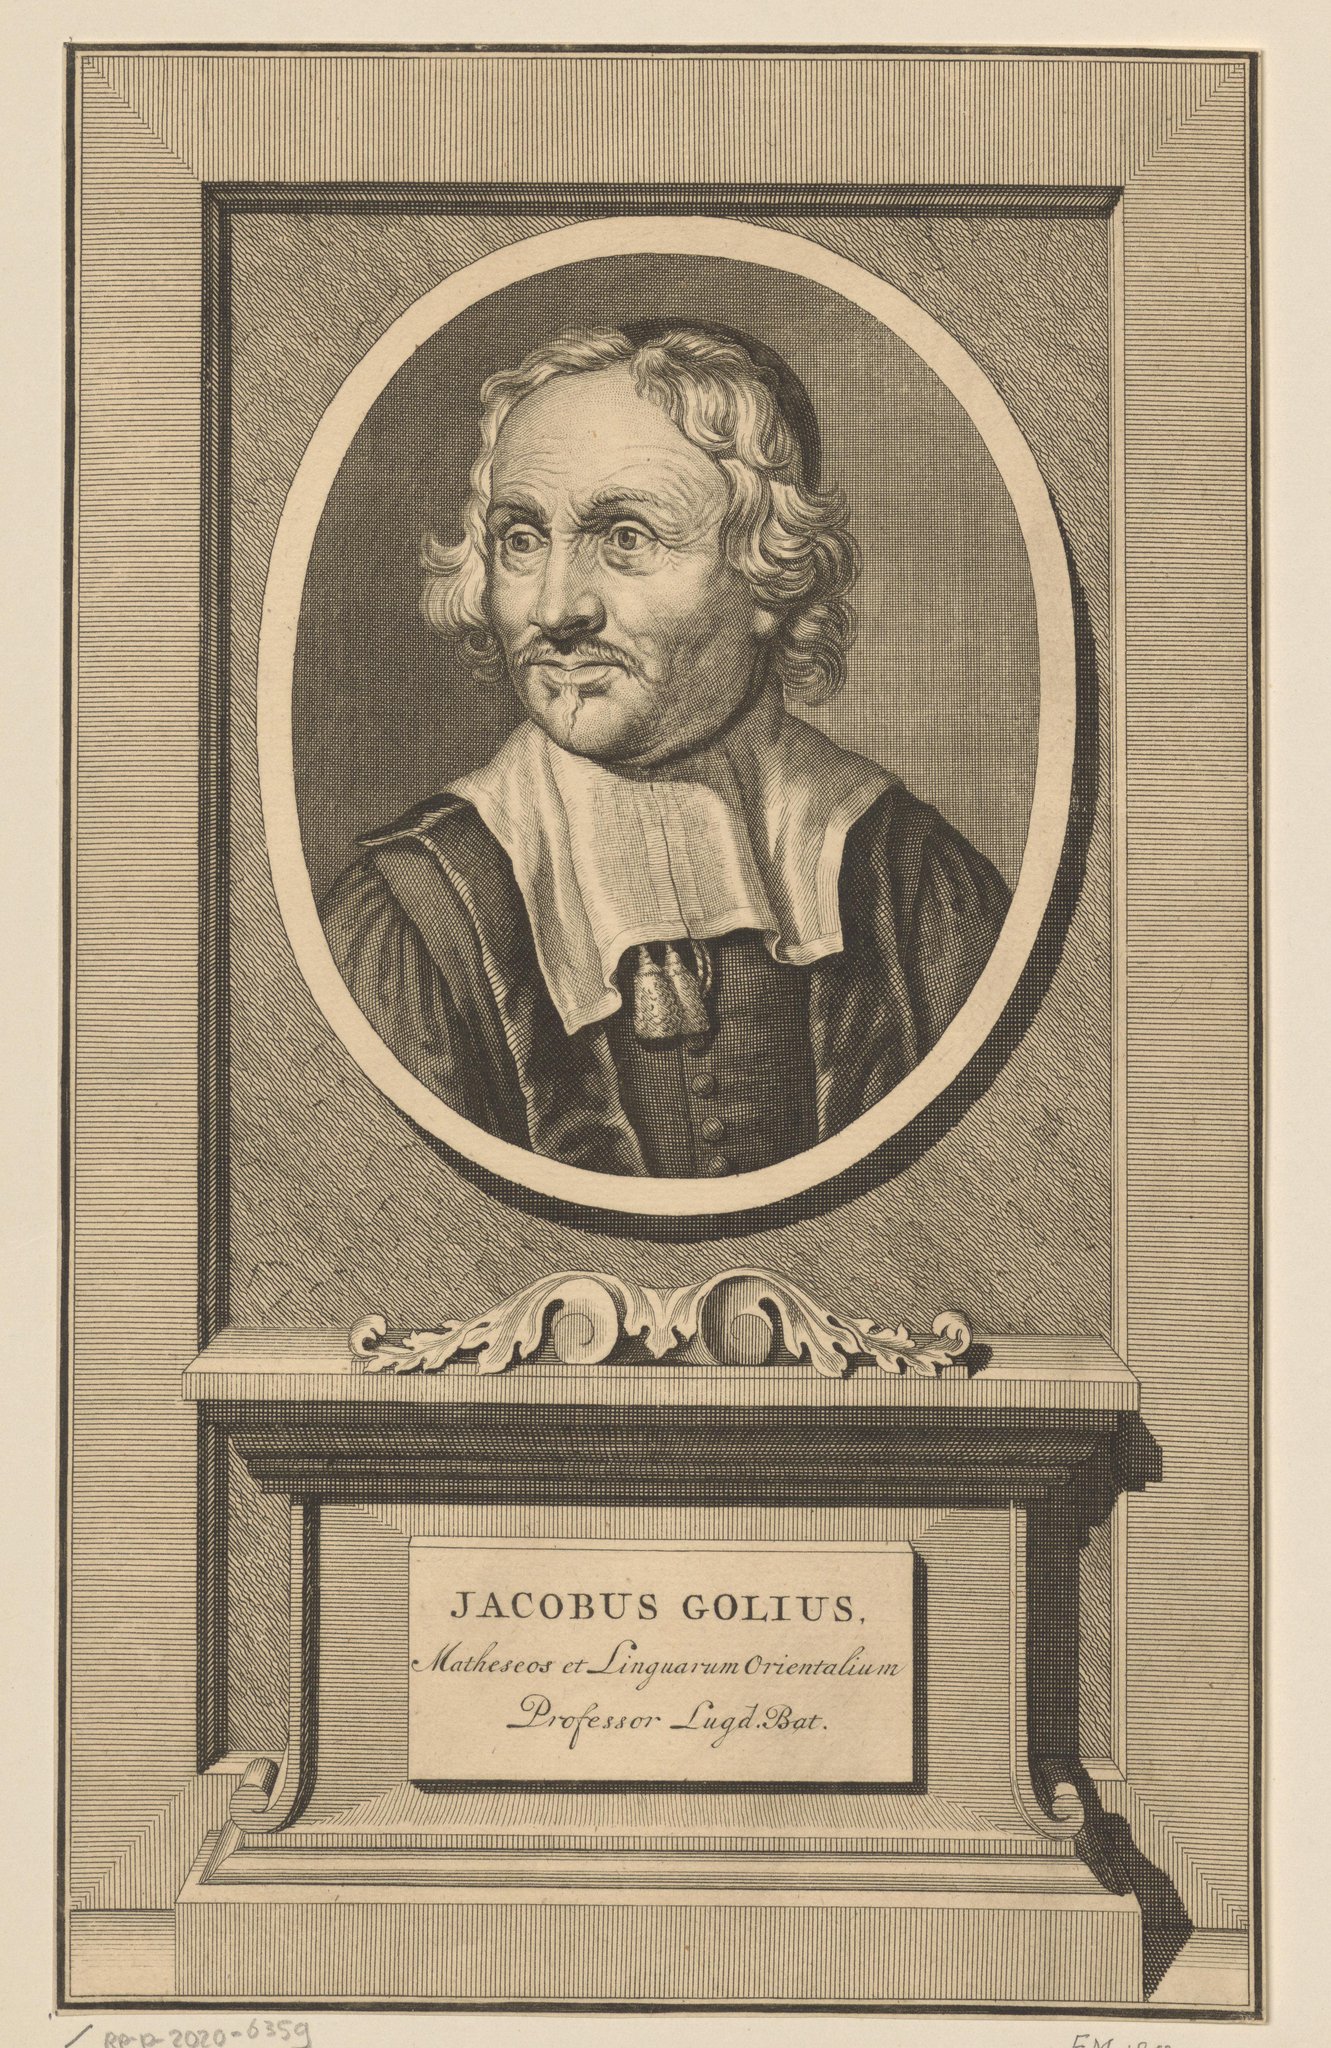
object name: print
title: Portret van Jacobus Golius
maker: Anonymous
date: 1650-1750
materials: paper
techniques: engraving, etching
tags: historical persons, professor